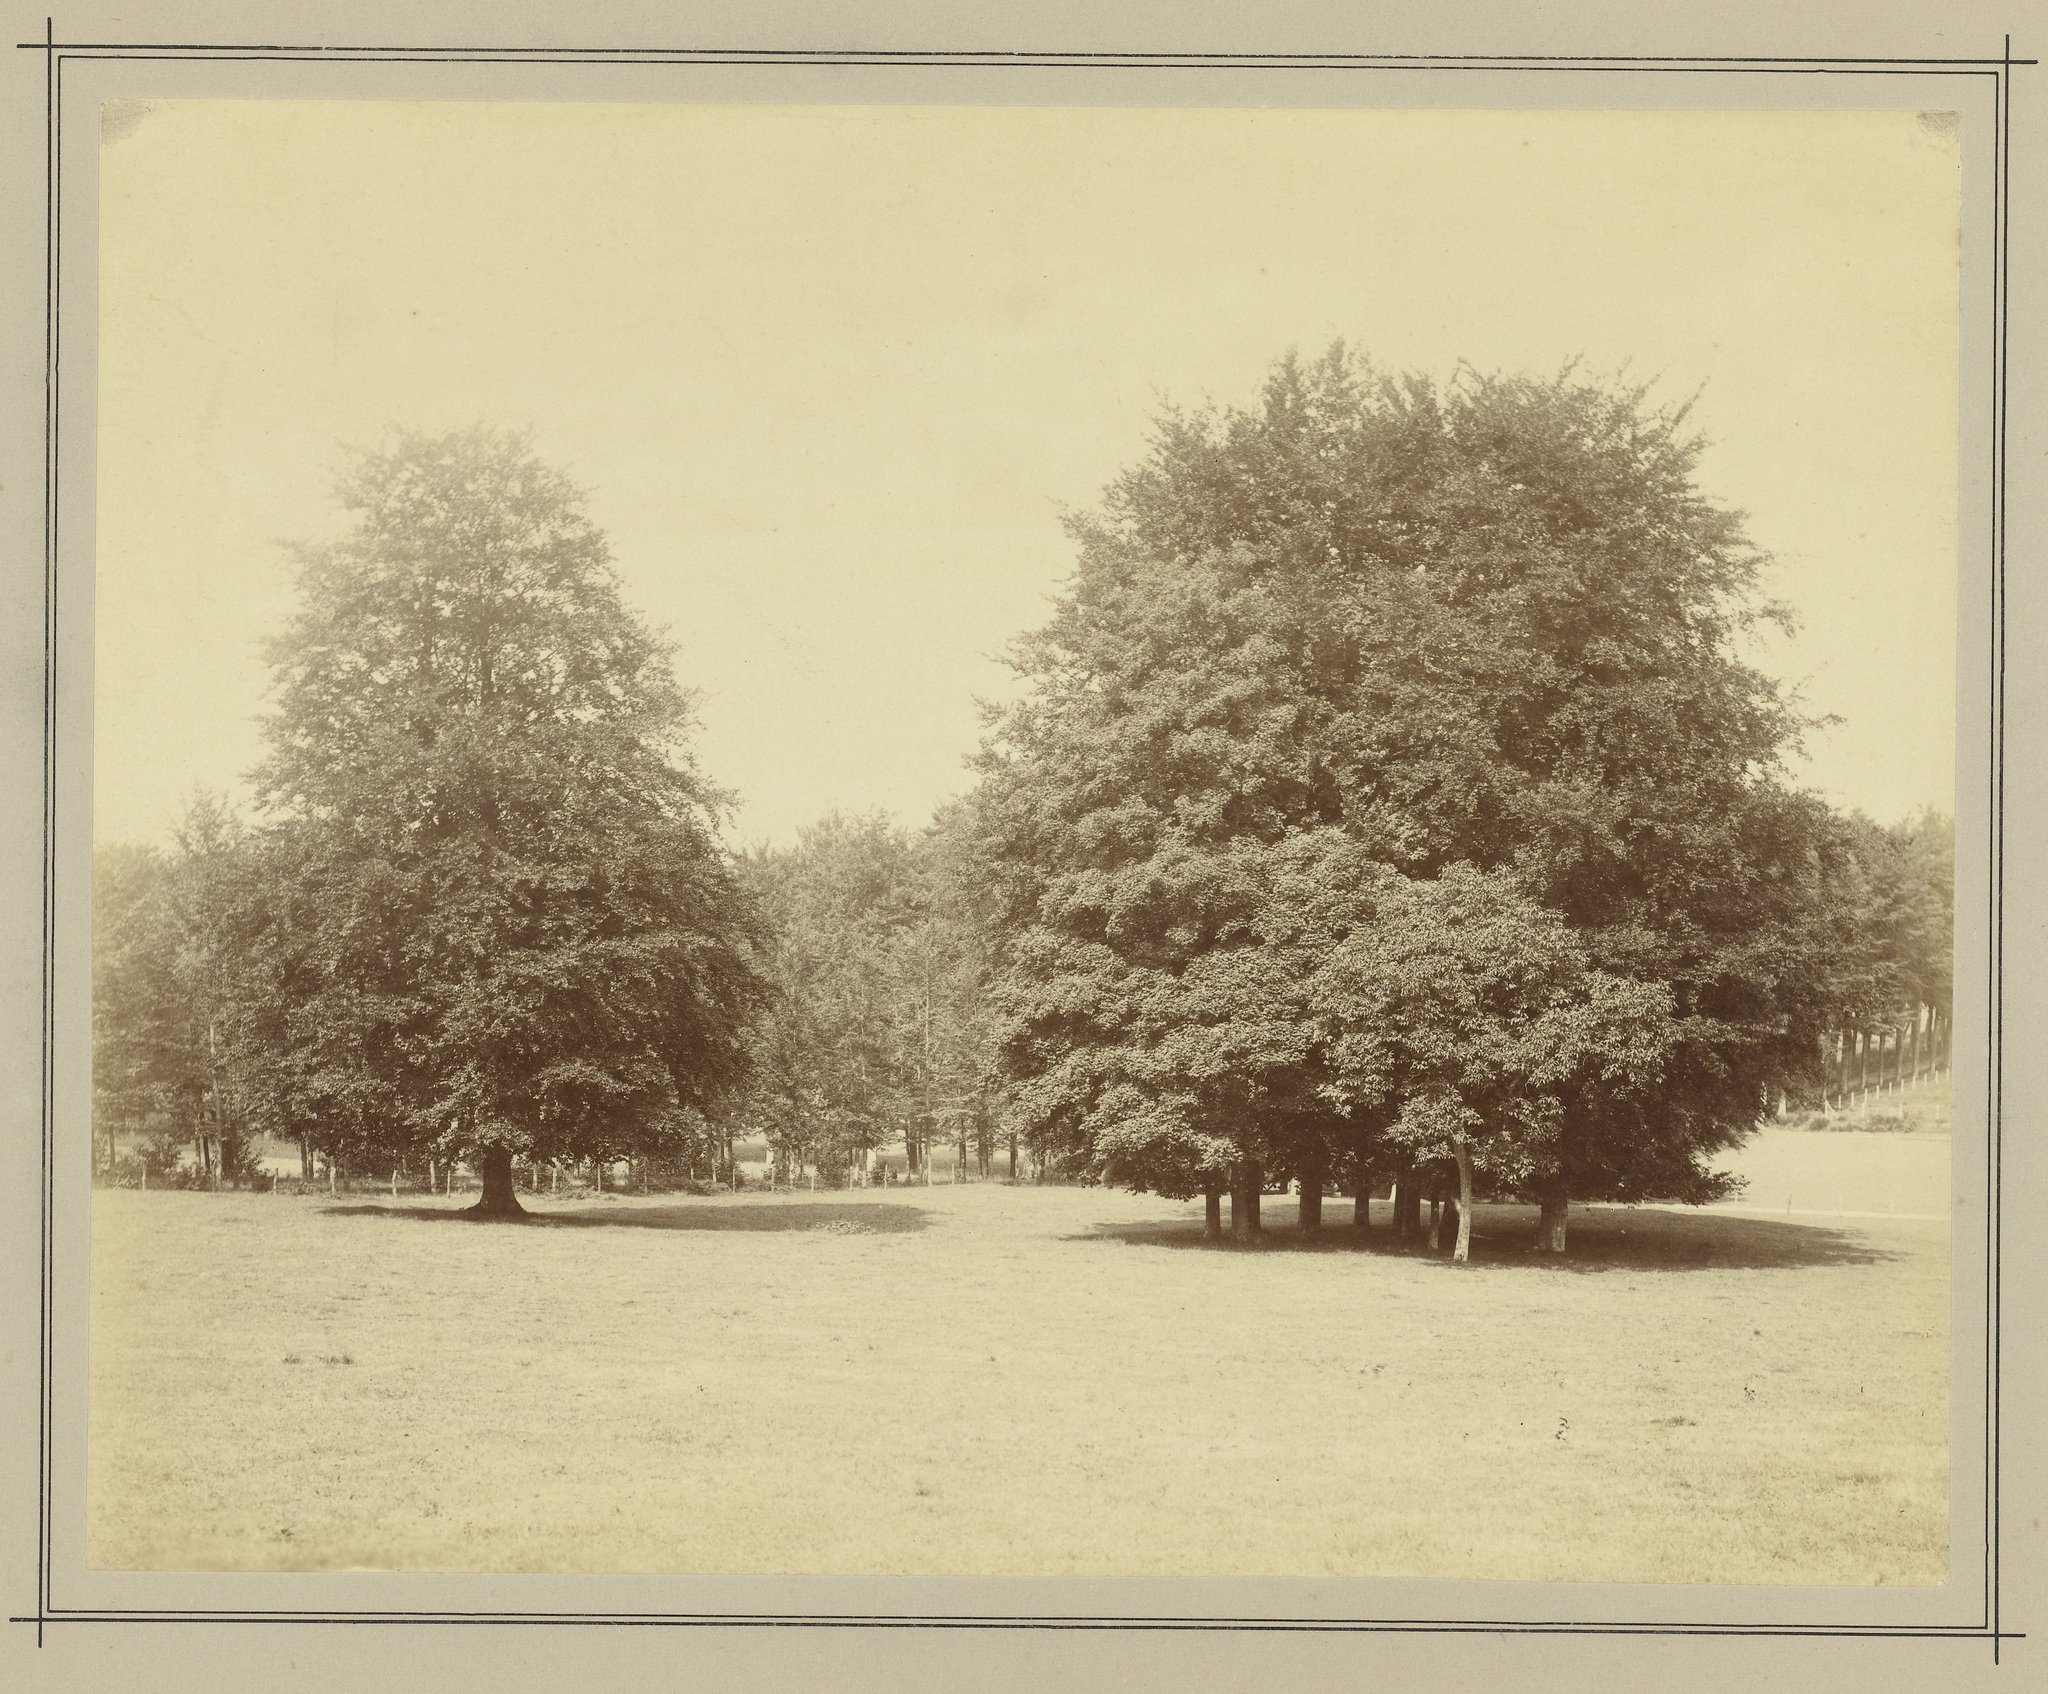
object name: photograph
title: Grote loofbomen op grasveld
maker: Anonymous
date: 1890-1910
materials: cardboard, paper, photographic support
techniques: albumen print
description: Grote loofbomen met vol gebladerte op uitgestrekt grasveld, geen mensen aanwezig.